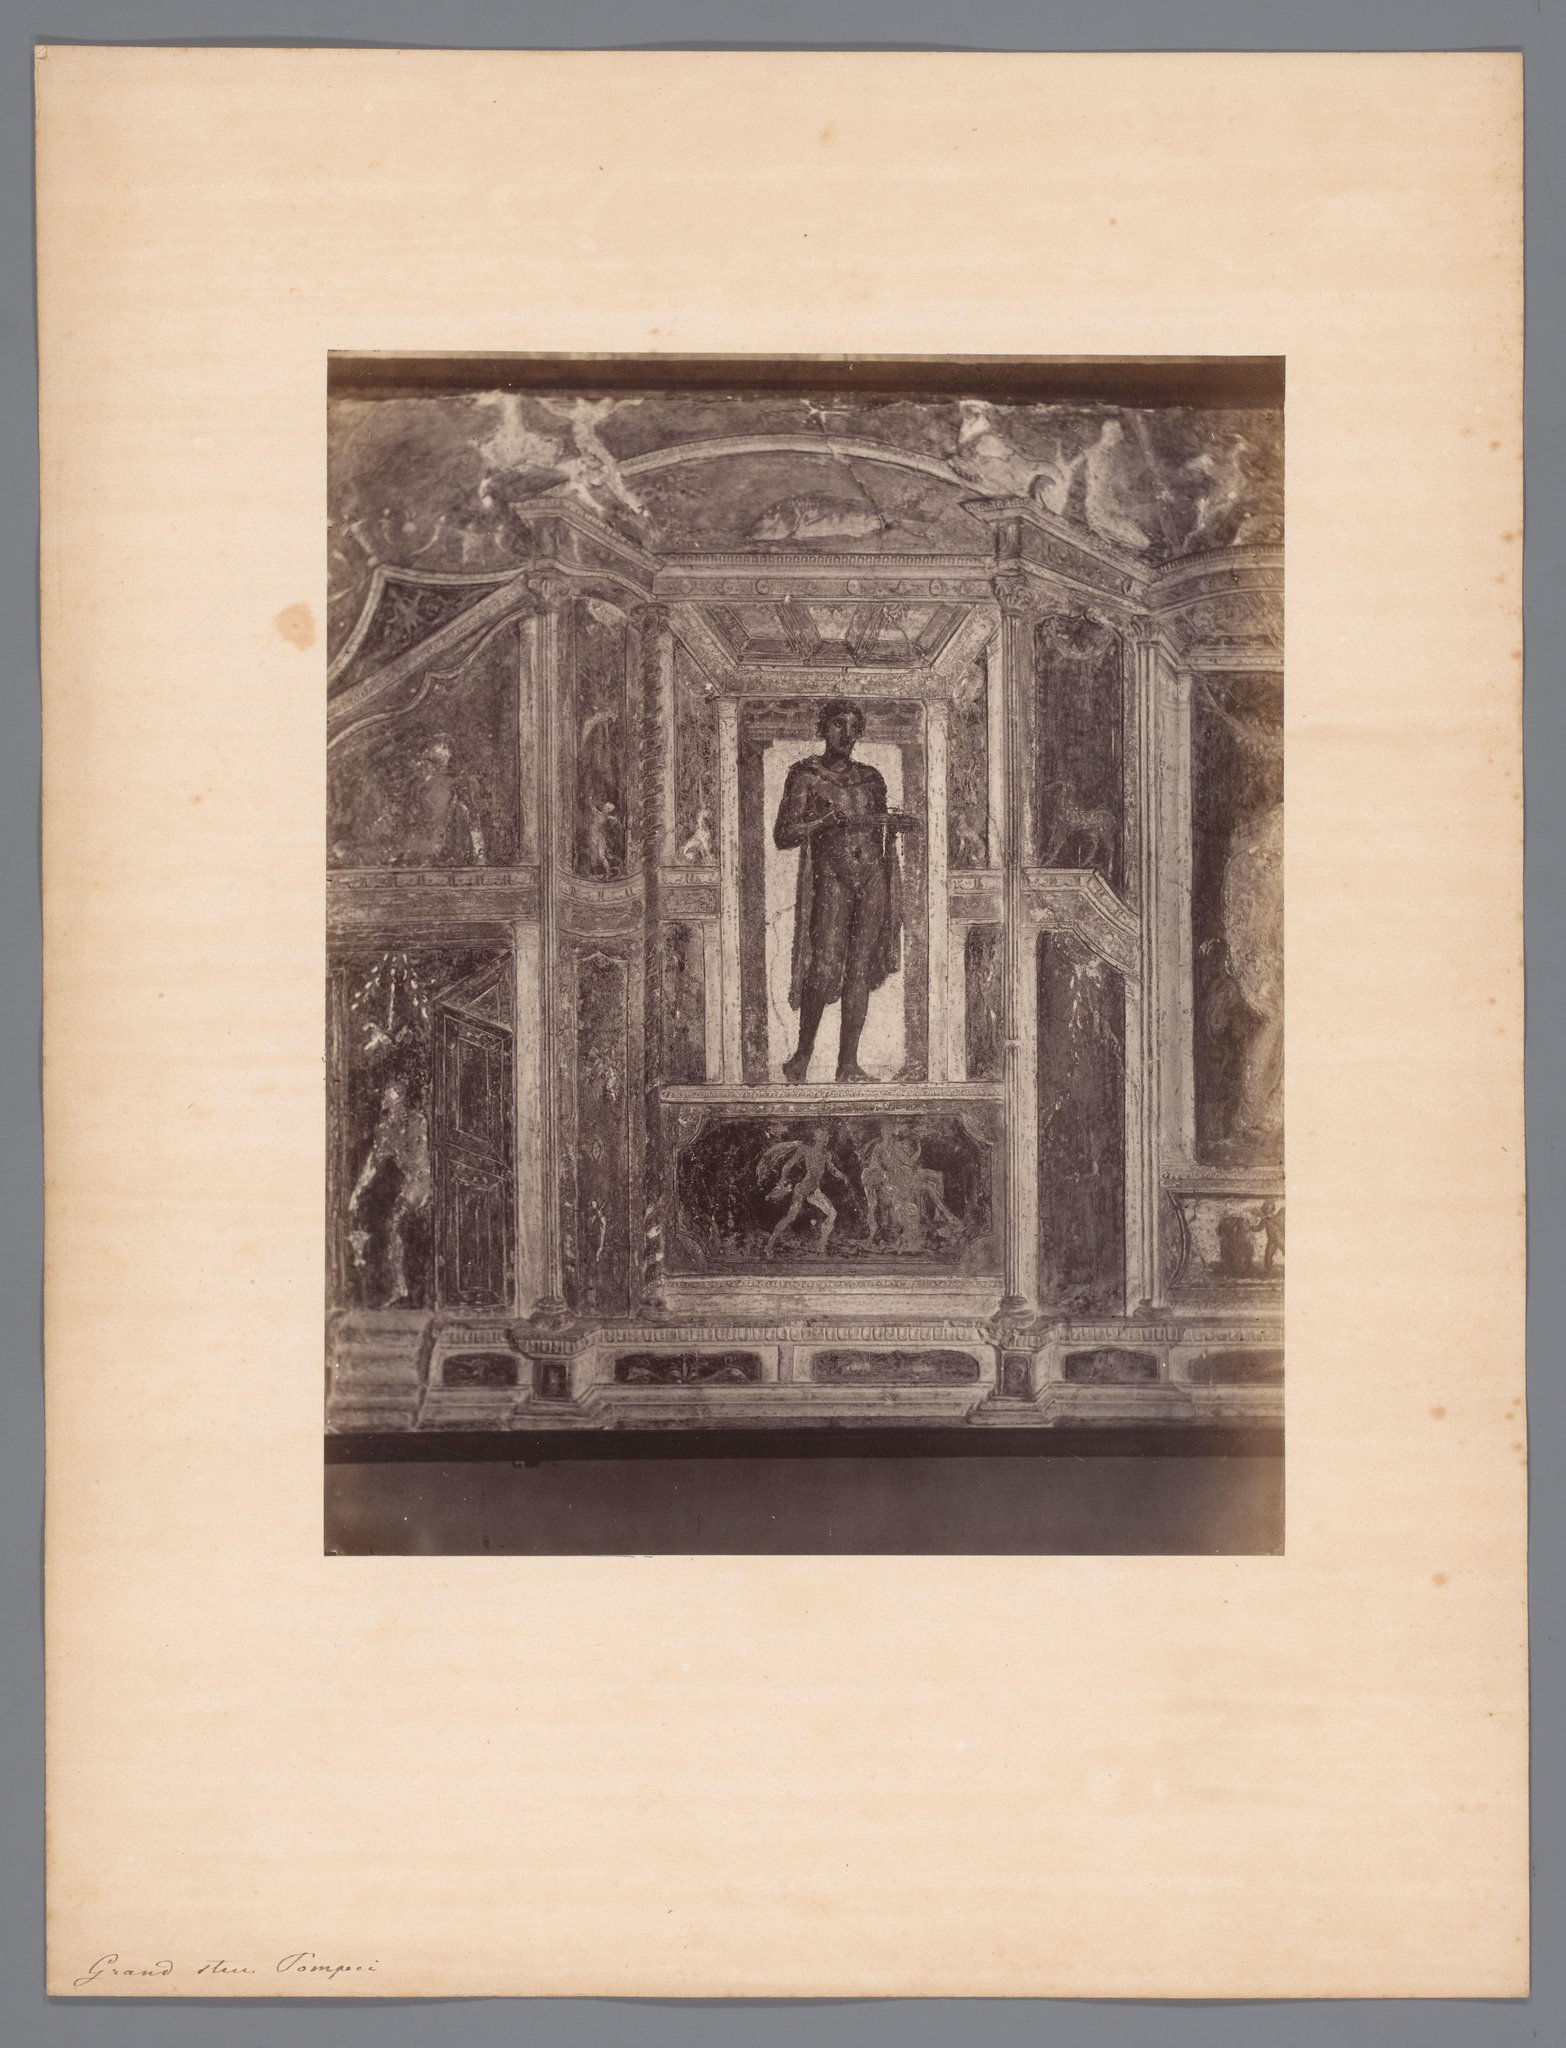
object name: photograph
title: Fotoreproductie van een fresco voorstellende een staande man te Pompeï, Italië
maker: Anonymous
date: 1851-1900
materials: cardboard, paper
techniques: albumen print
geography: pompeii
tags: picture, painting, wall-covering, pompeii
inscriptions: number: ‘11’, inscription: ‘Grand [...] Pompei’, number: ‘74.’